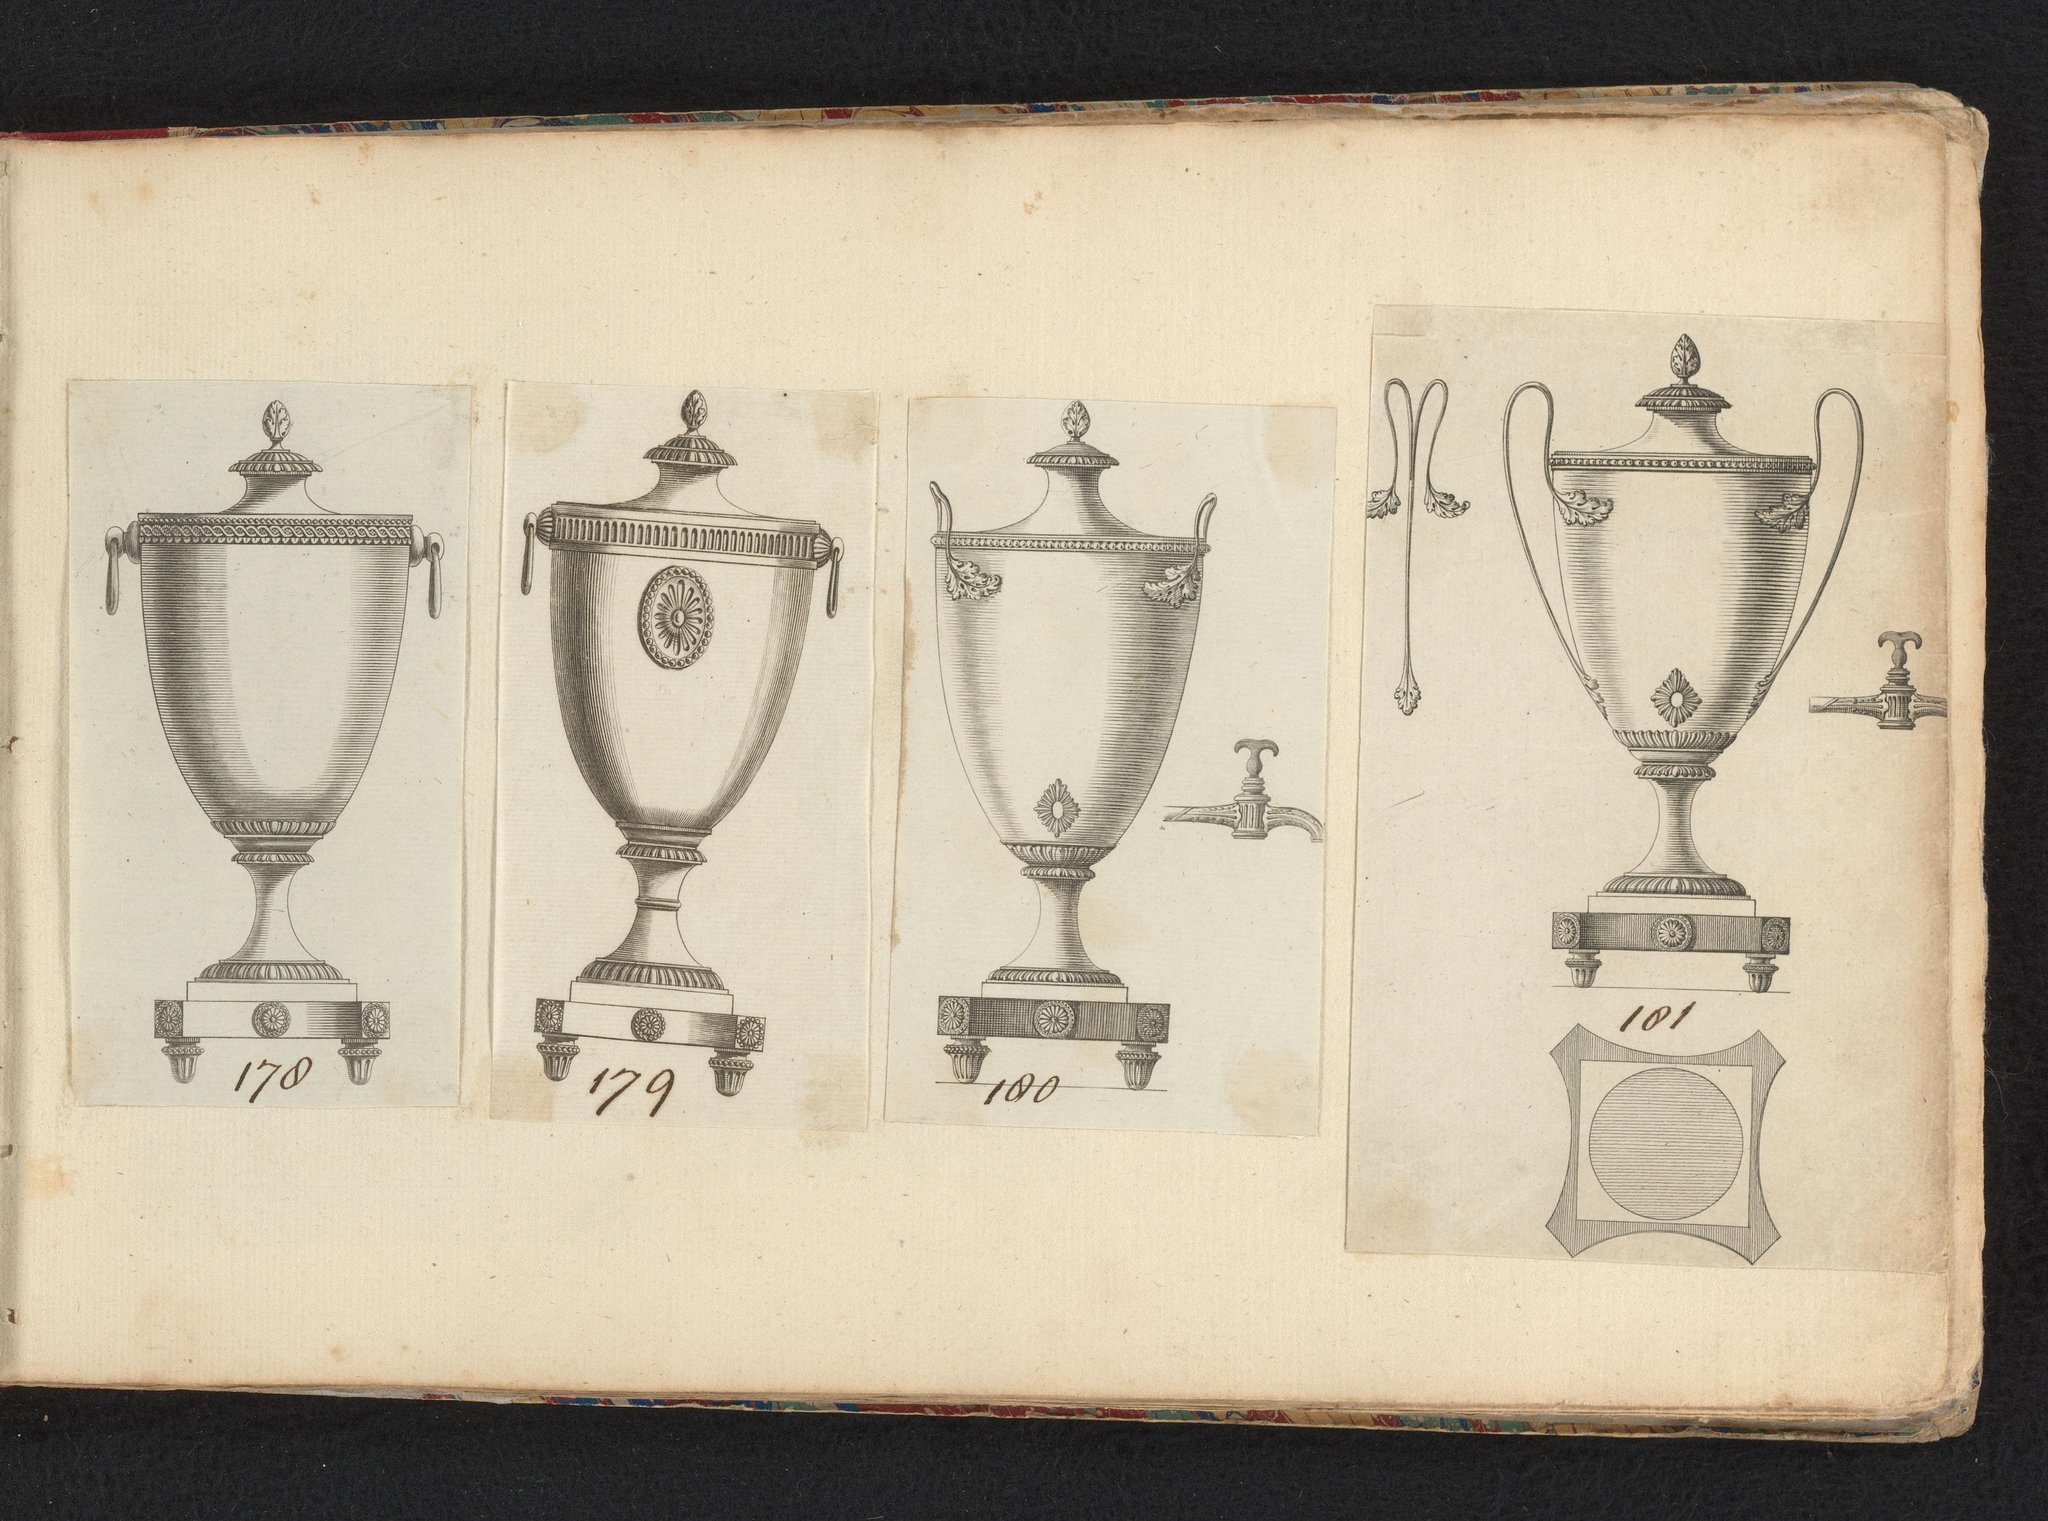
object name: album leaf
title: Ontwerpen voor koffieketels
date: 1784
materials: paper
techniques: engraving, etching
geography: england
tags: tea- and coffee-service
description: Blad met vier ingeplakte bladen met ontwerpen voor koffieketels. Met handgeschreven nrs. 178-181. Onderdeel van een catalogus met assortiment modellen van Sheffield verzilverd vaatwerk (pleet) door Matthew Boulton.